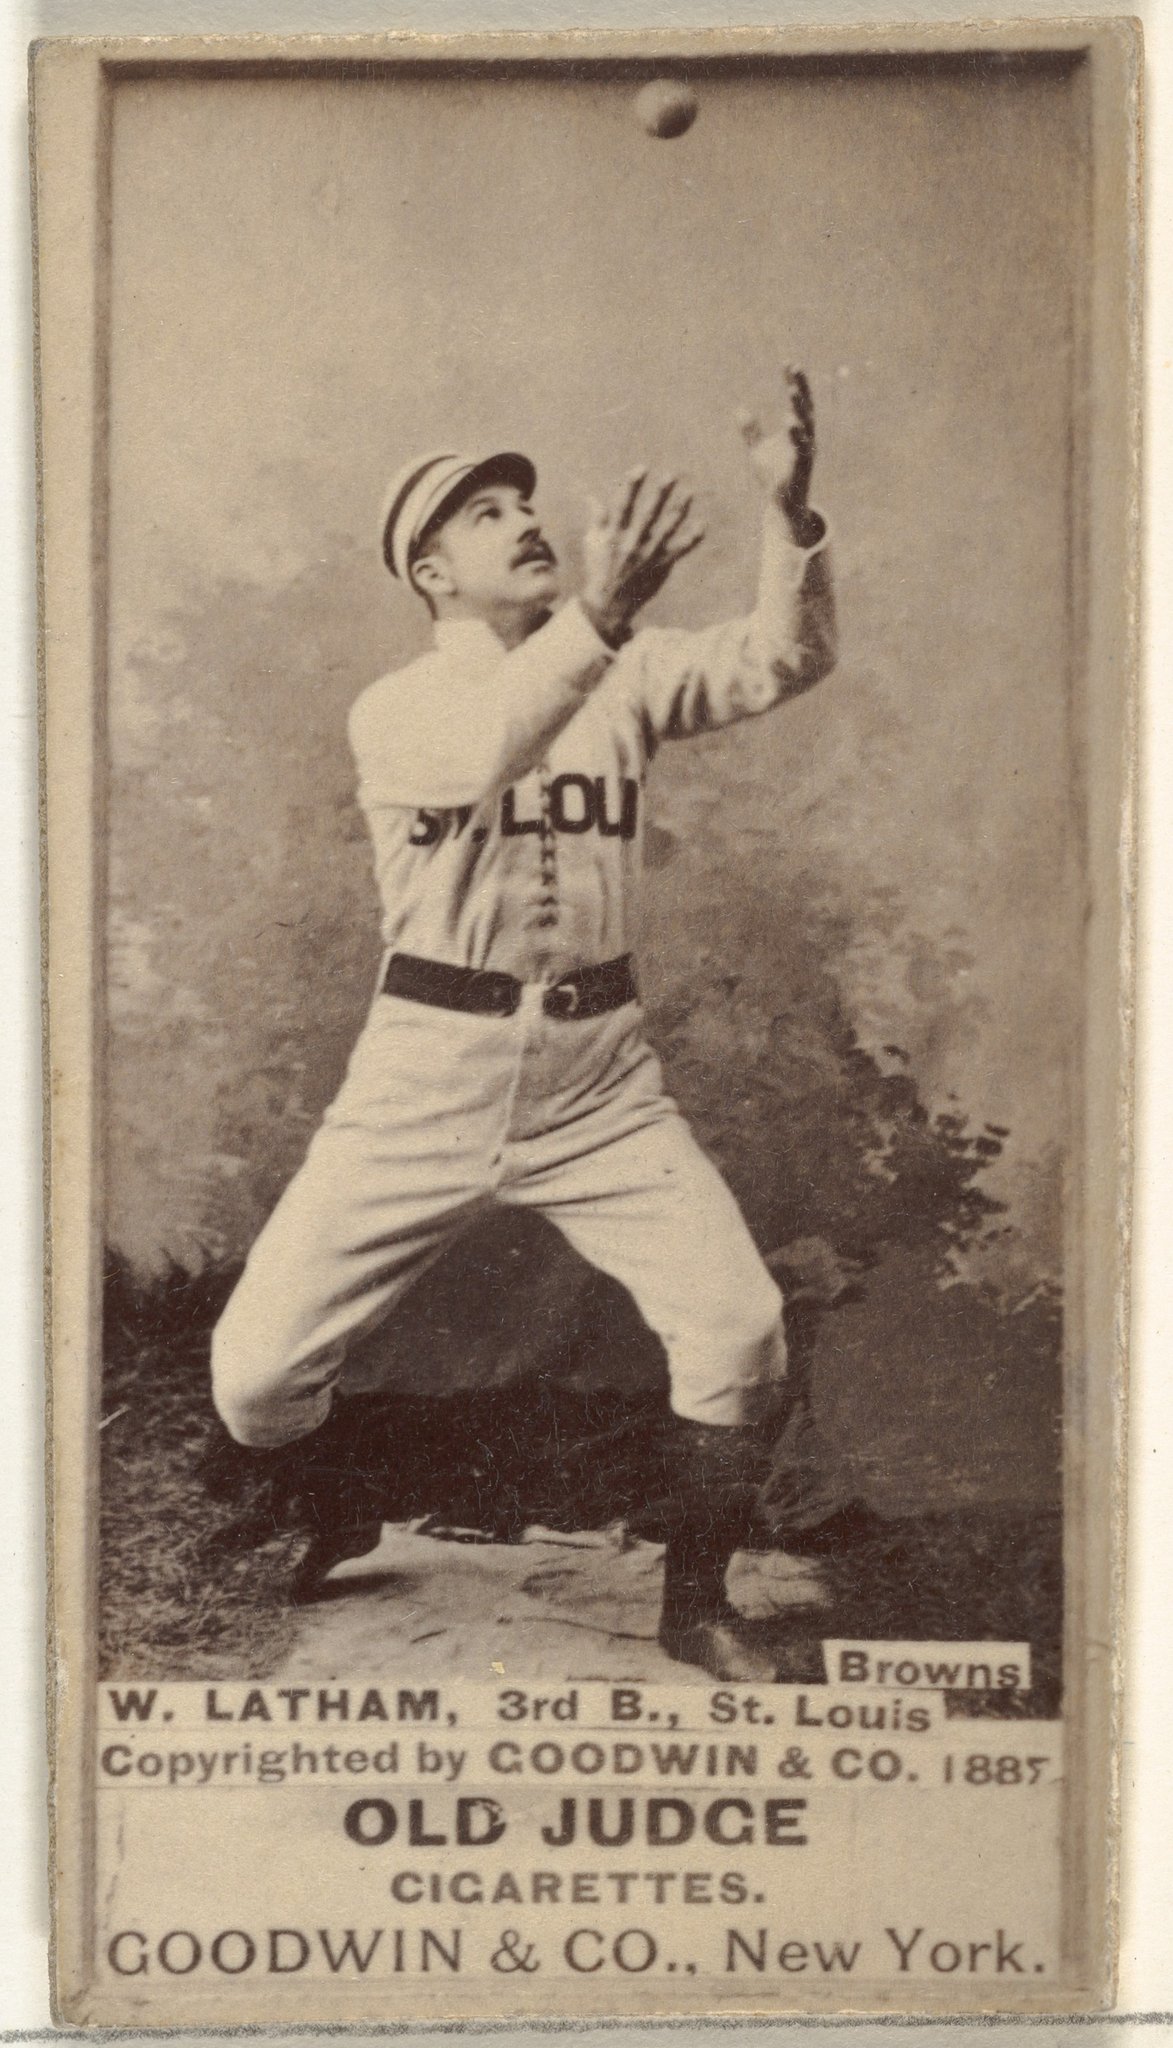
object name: baseball card, photograph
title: Arlie Latham, 3rd Base, St. Louis Browns, from the Old Judge series (N172) for Old Judge Cigarettes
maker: goodwin & company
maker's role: publisher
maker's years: 1850-1950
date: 1889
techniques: albumen silver print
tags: men,portraits,baseball,athletes